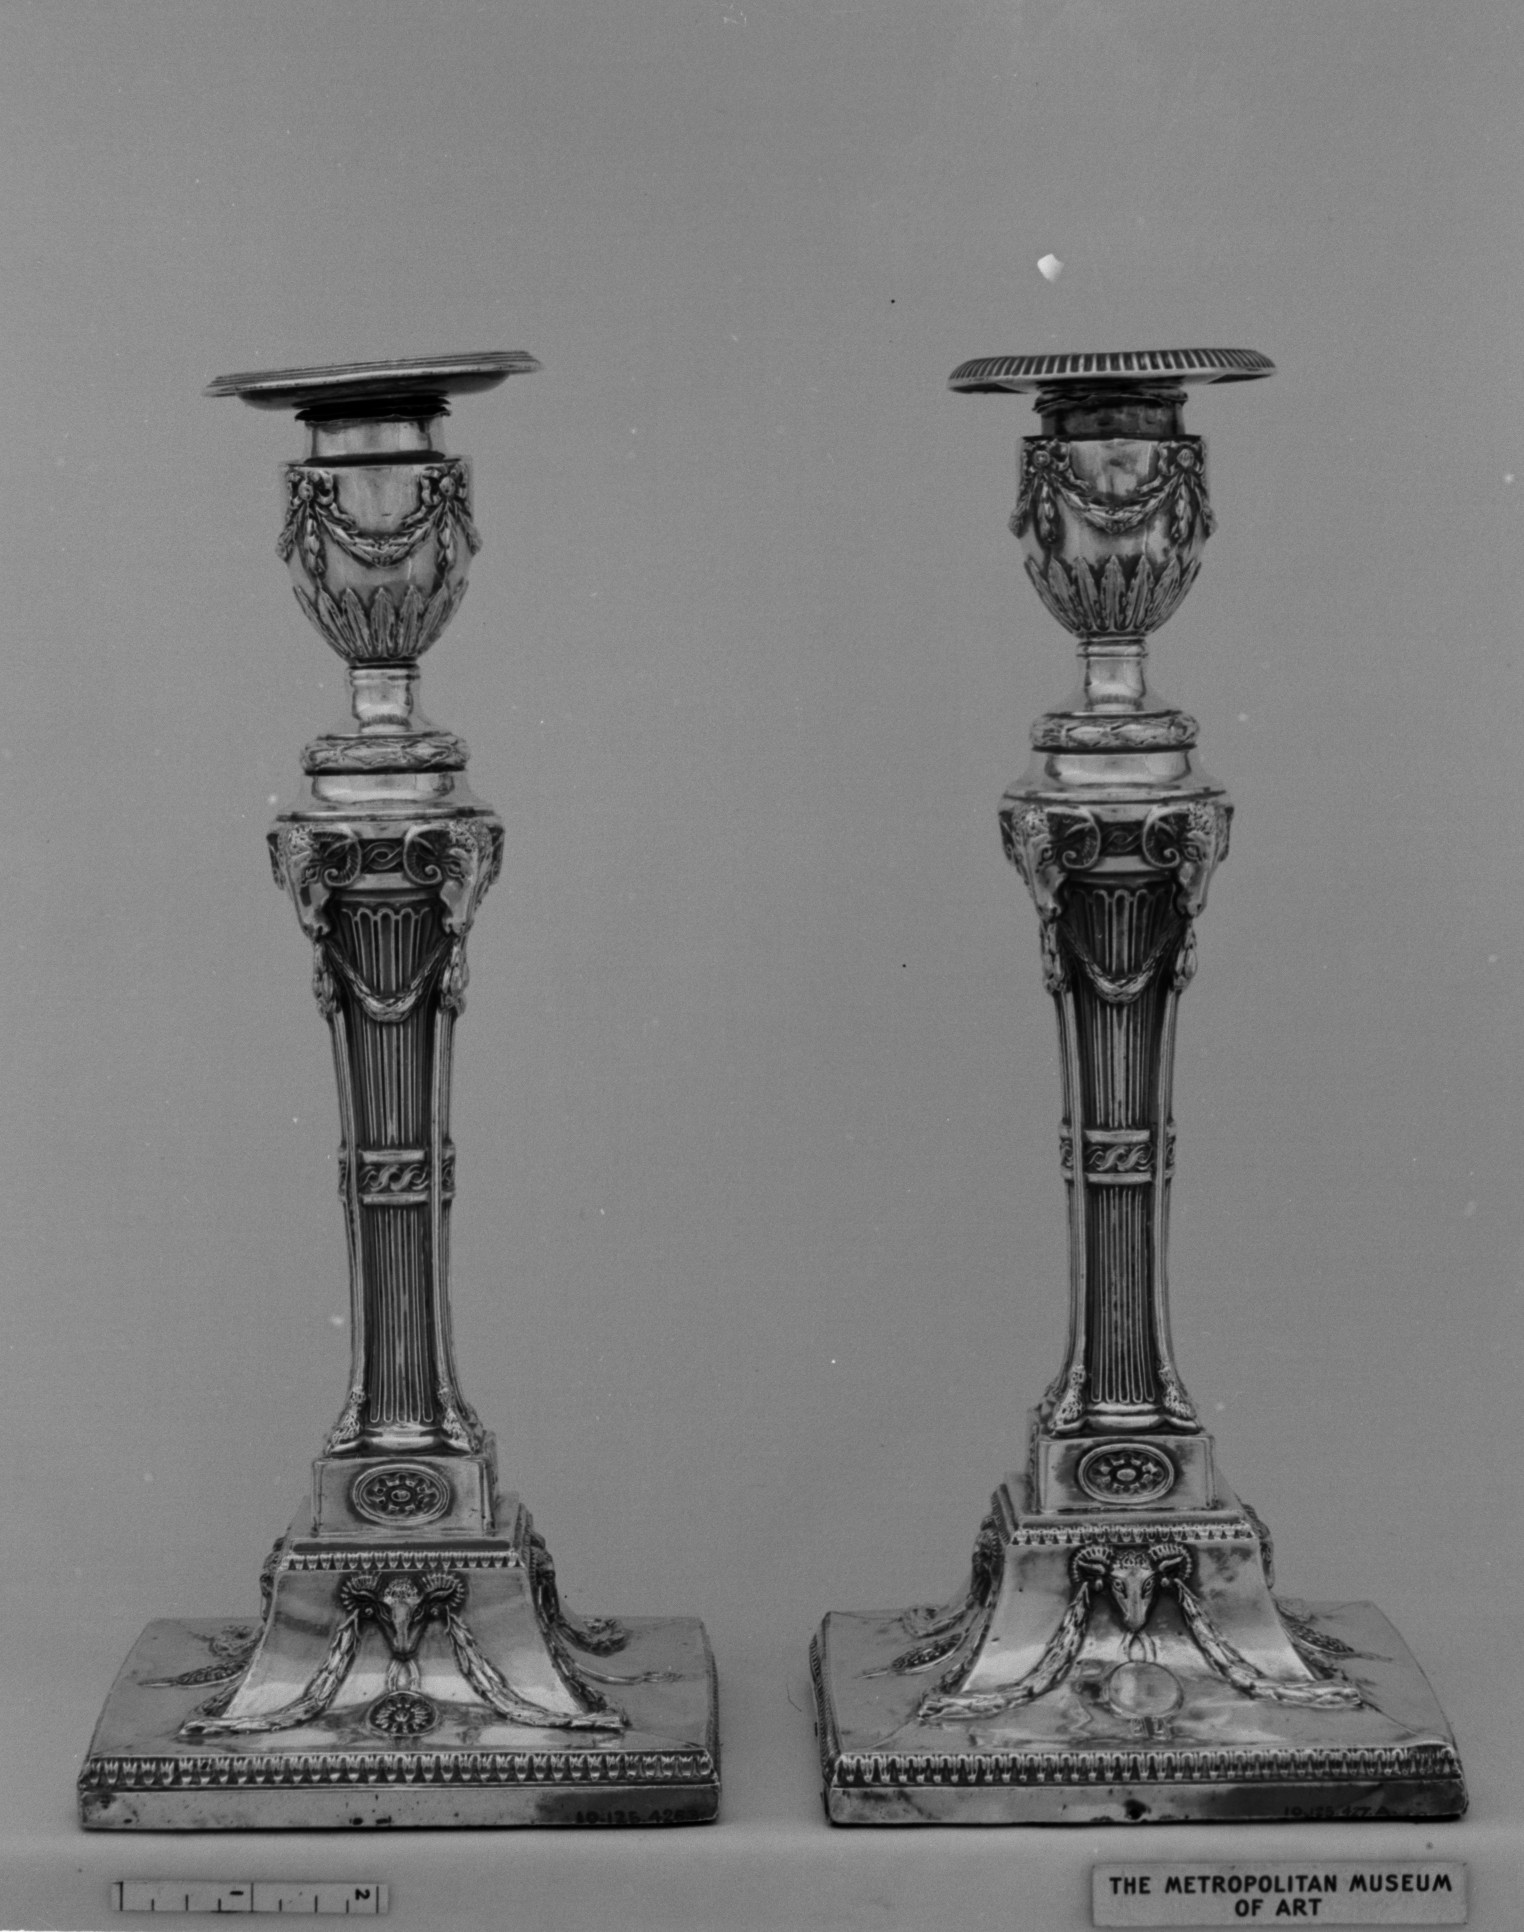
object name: candlestick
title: Pair of candlesticks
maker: john winter and co.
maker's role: maker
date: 1777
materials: metal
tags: animals